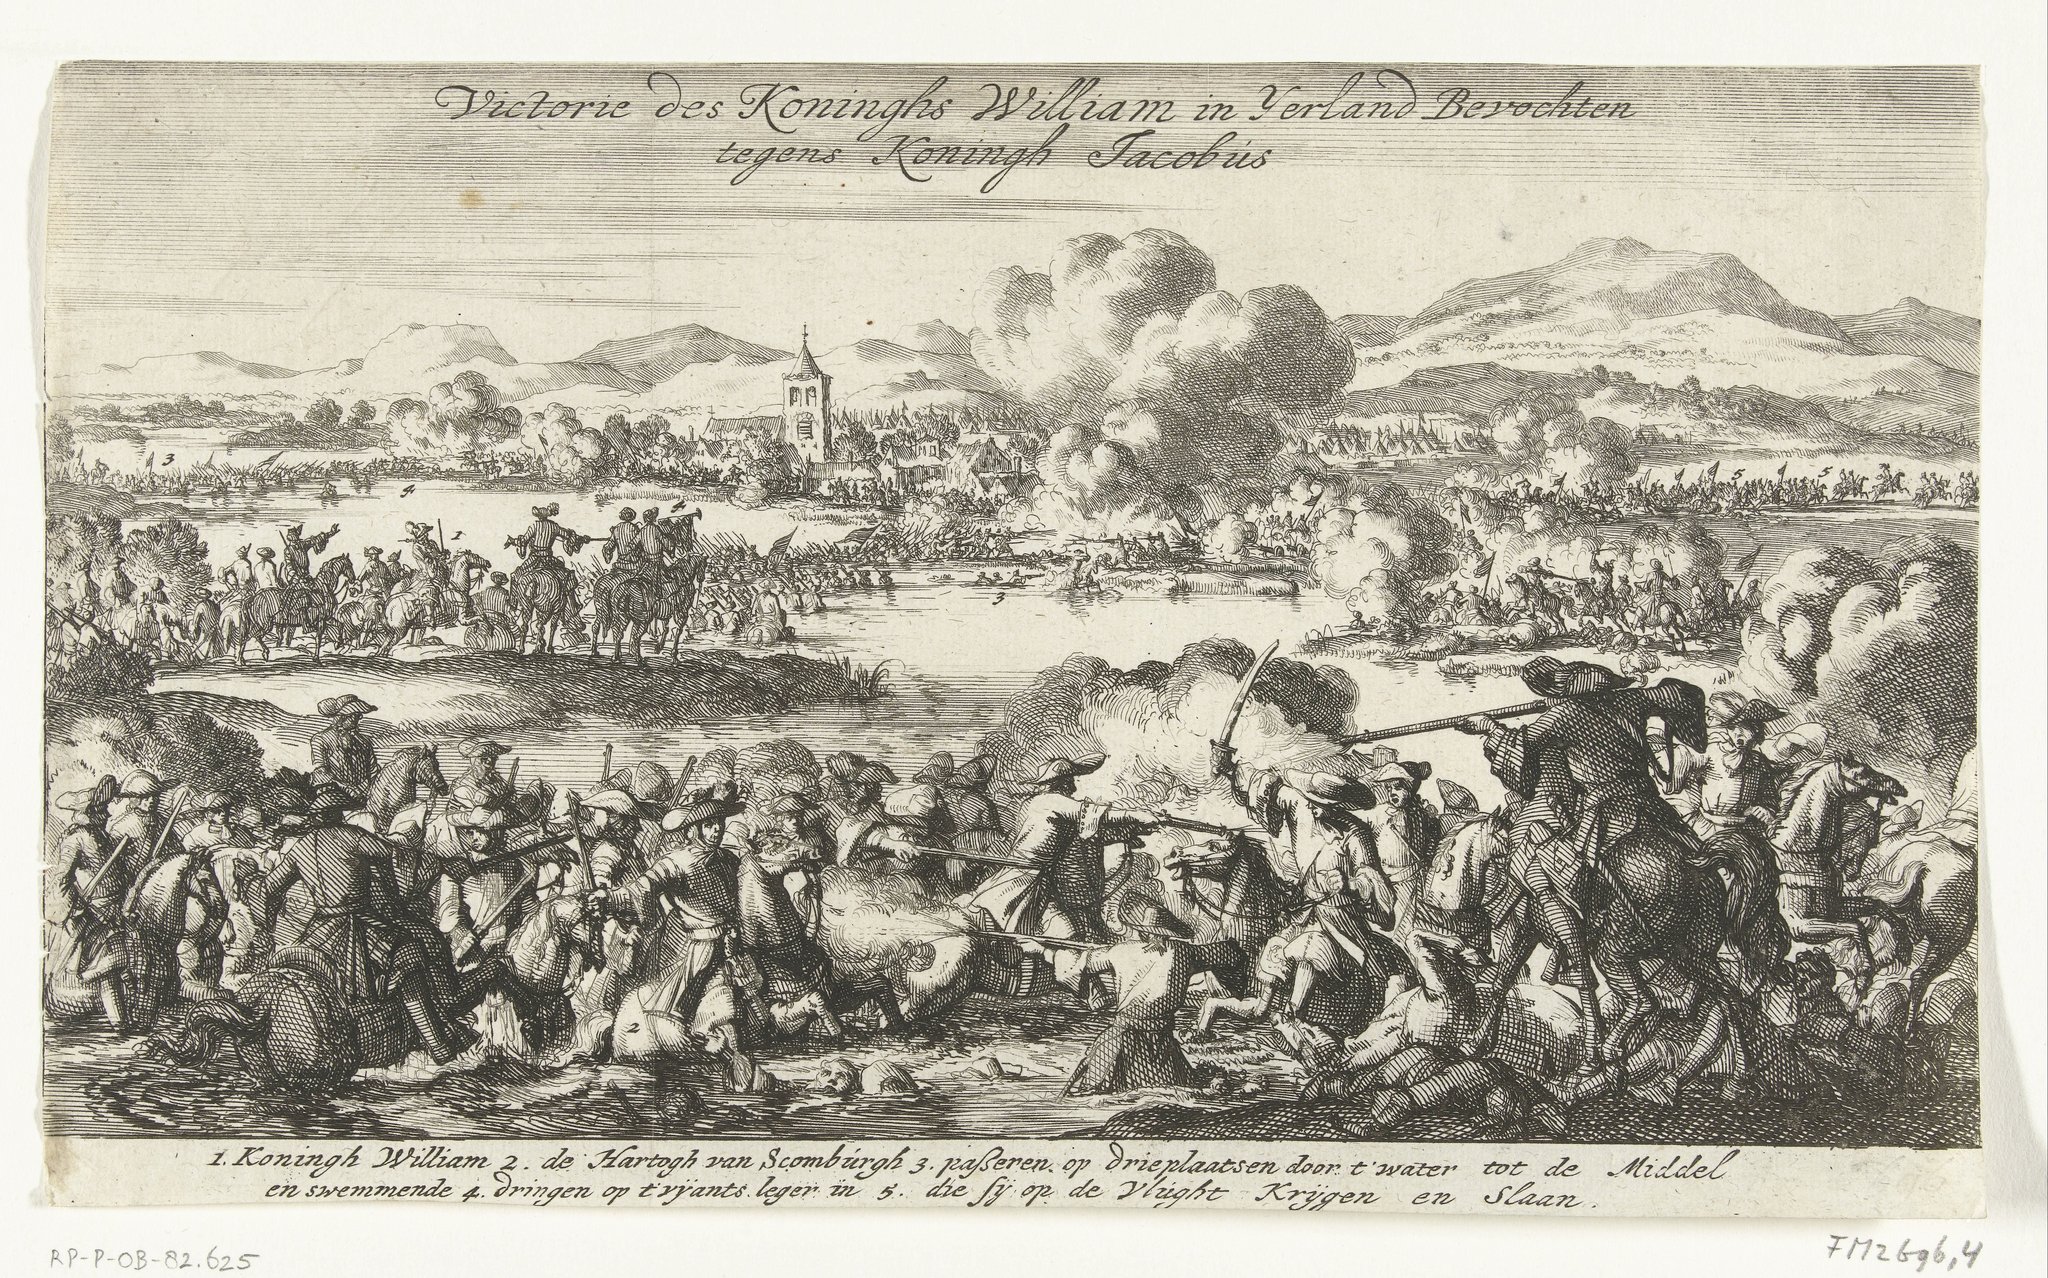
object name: print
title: Victorie des Koninghs William in Yerland Bevochten tegen Koningh Jacobus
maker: jan luyken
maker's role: draughtsman, print maker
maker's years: 1649-1712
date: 1690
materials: paper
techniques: etching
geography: northern netherlands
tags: william iii (prince of orange and king of england, scotland, and ireland), battle (+ land forces)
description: Gebruikt als illustratie in: Lambert van den Bosch, Yerlant verlost en hersteld, door den onvermoeide victorieuzen William de IIIde, Jan Claesz ten Hoorn, Amsterdam 1690, fol. 53. Deze prent is ook genummerd FMH 2696 als illustratie voor: Lambert van den Bosch, Het leven en bedryf van Willem de Darde, Jan Claesz ten Hoorn, Amsterdam 1694, 4 delen.